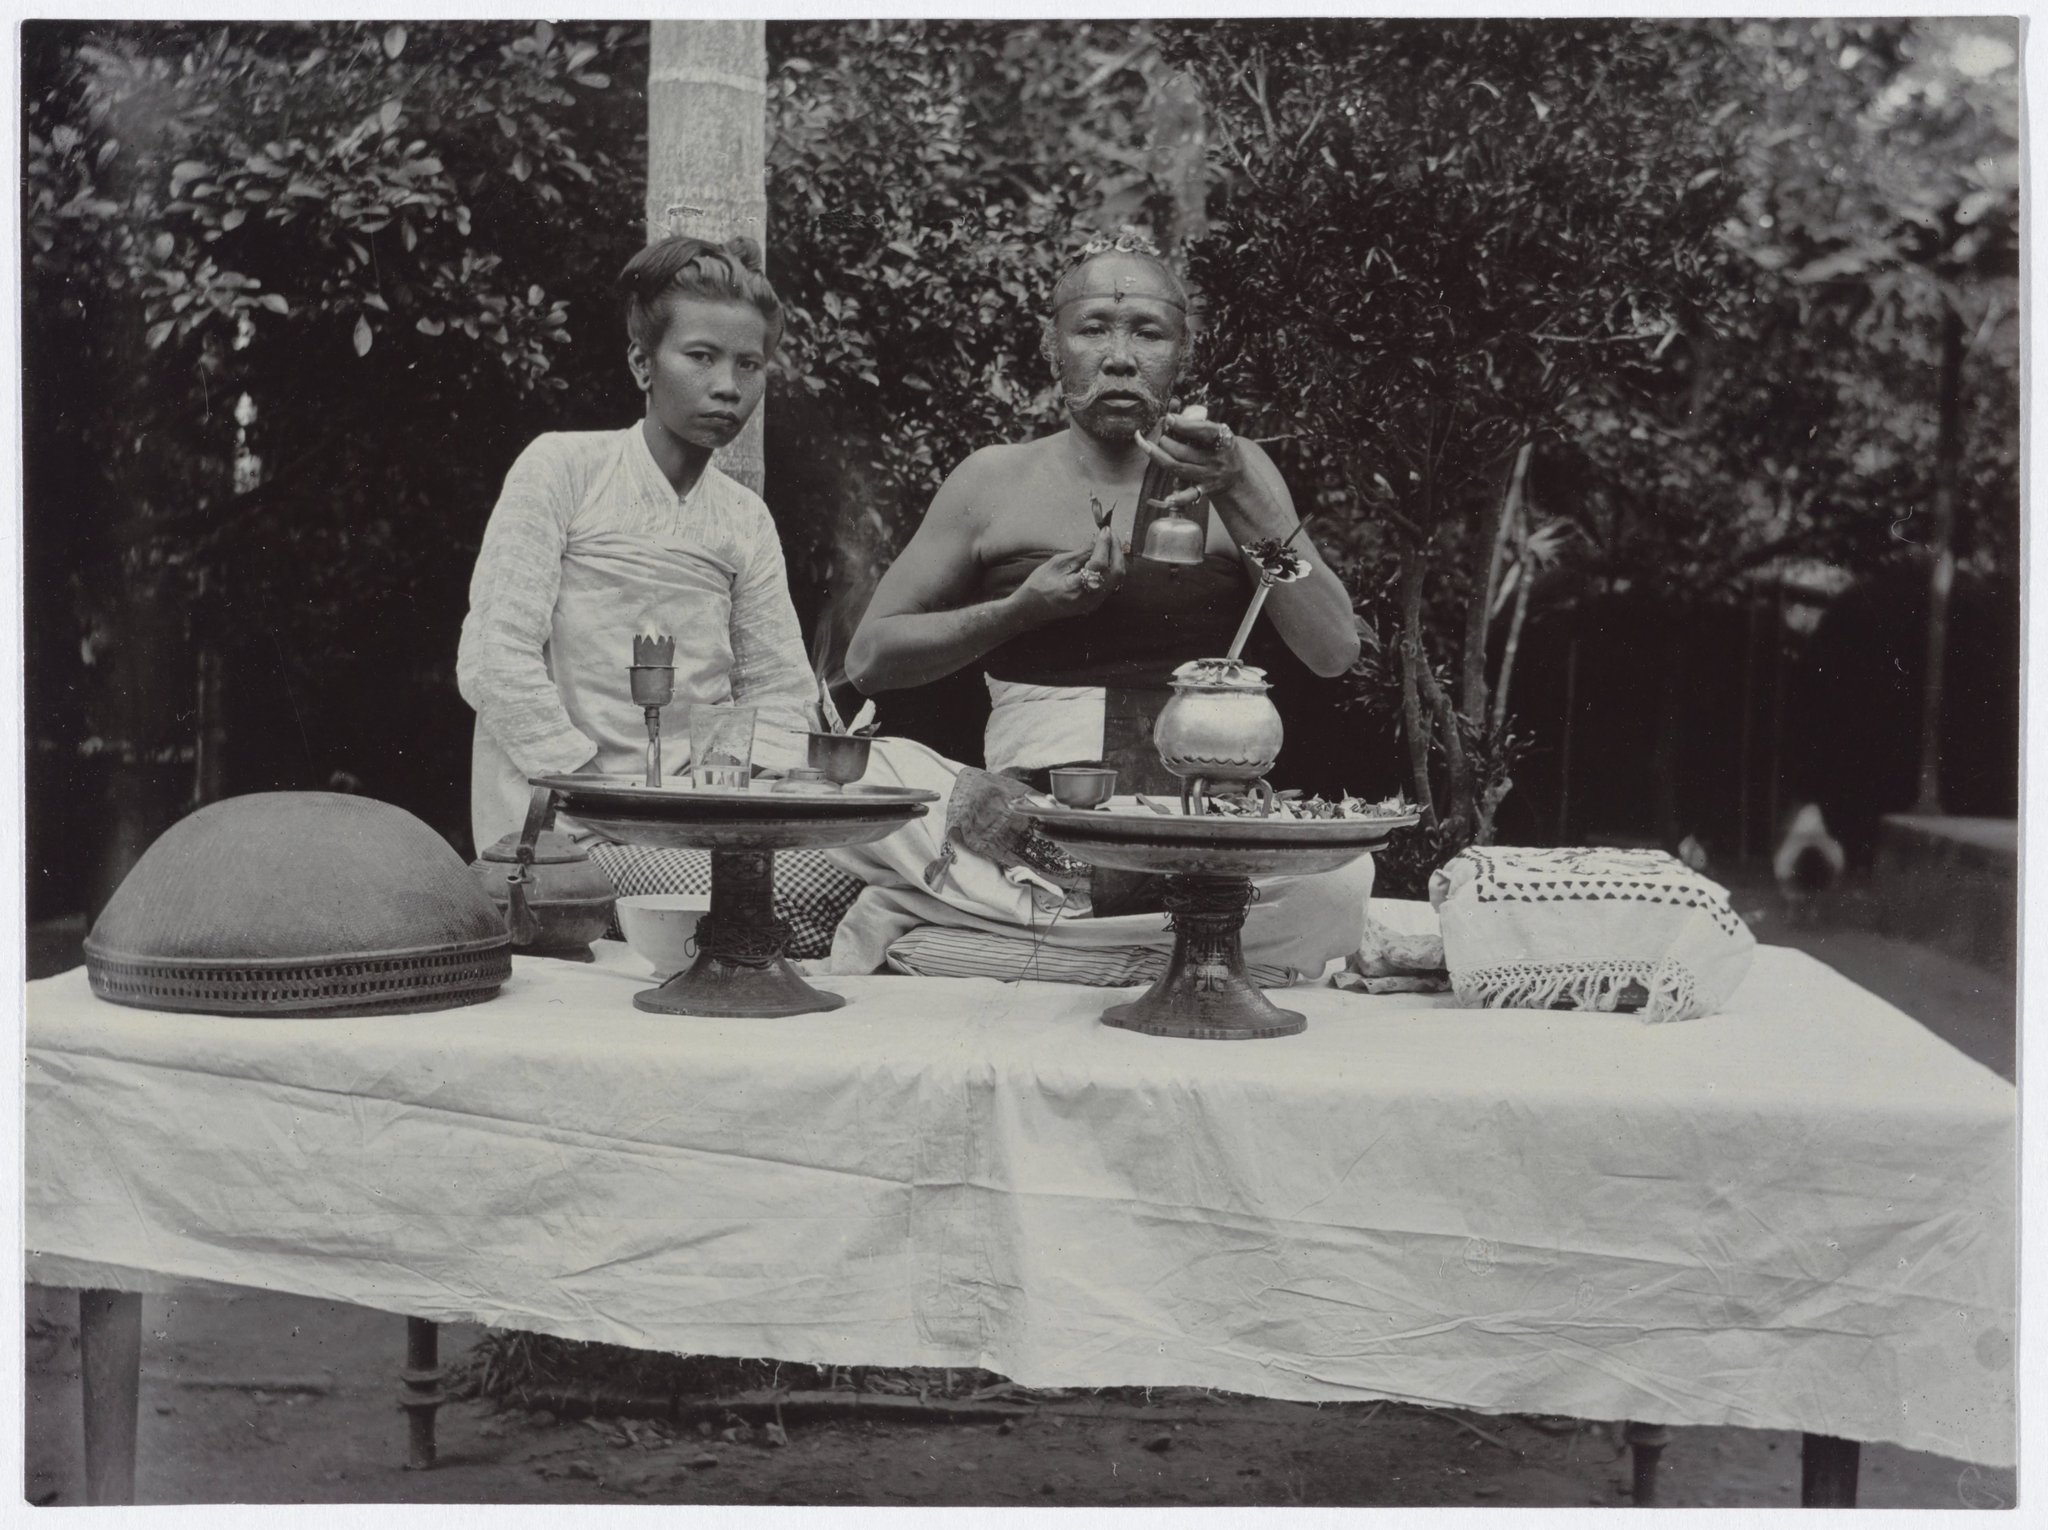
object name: photograph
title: Een Pedanda aan het werk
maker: johanna hermina marmelstein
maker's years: 1897-1990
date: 1900-1915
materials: paper, photographic support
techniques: albumen print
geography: jakarta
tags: bali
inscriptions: annotation: ‘18. Noord-Bali. Pedanda (= priester) Paetoe Gria te Singaradja in de uitoefening van zijn priesterambt, bijgestaan door istri (vrouwelijke helpster). Let op de 3 rijstkorrels op zijn voorhoofd geplakt (deze hebben een zekere heilige betekenis inzake vruchtbaarheid) en op de lange nagels, het bewijs dat de leden der Brahmanen kaste geen gemeen werk verrichten.’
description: De pedanda vormen de hoogste kaste op Bali, zij hebben een religieuze functie bij het uitvoeren van rituelen en tradities.